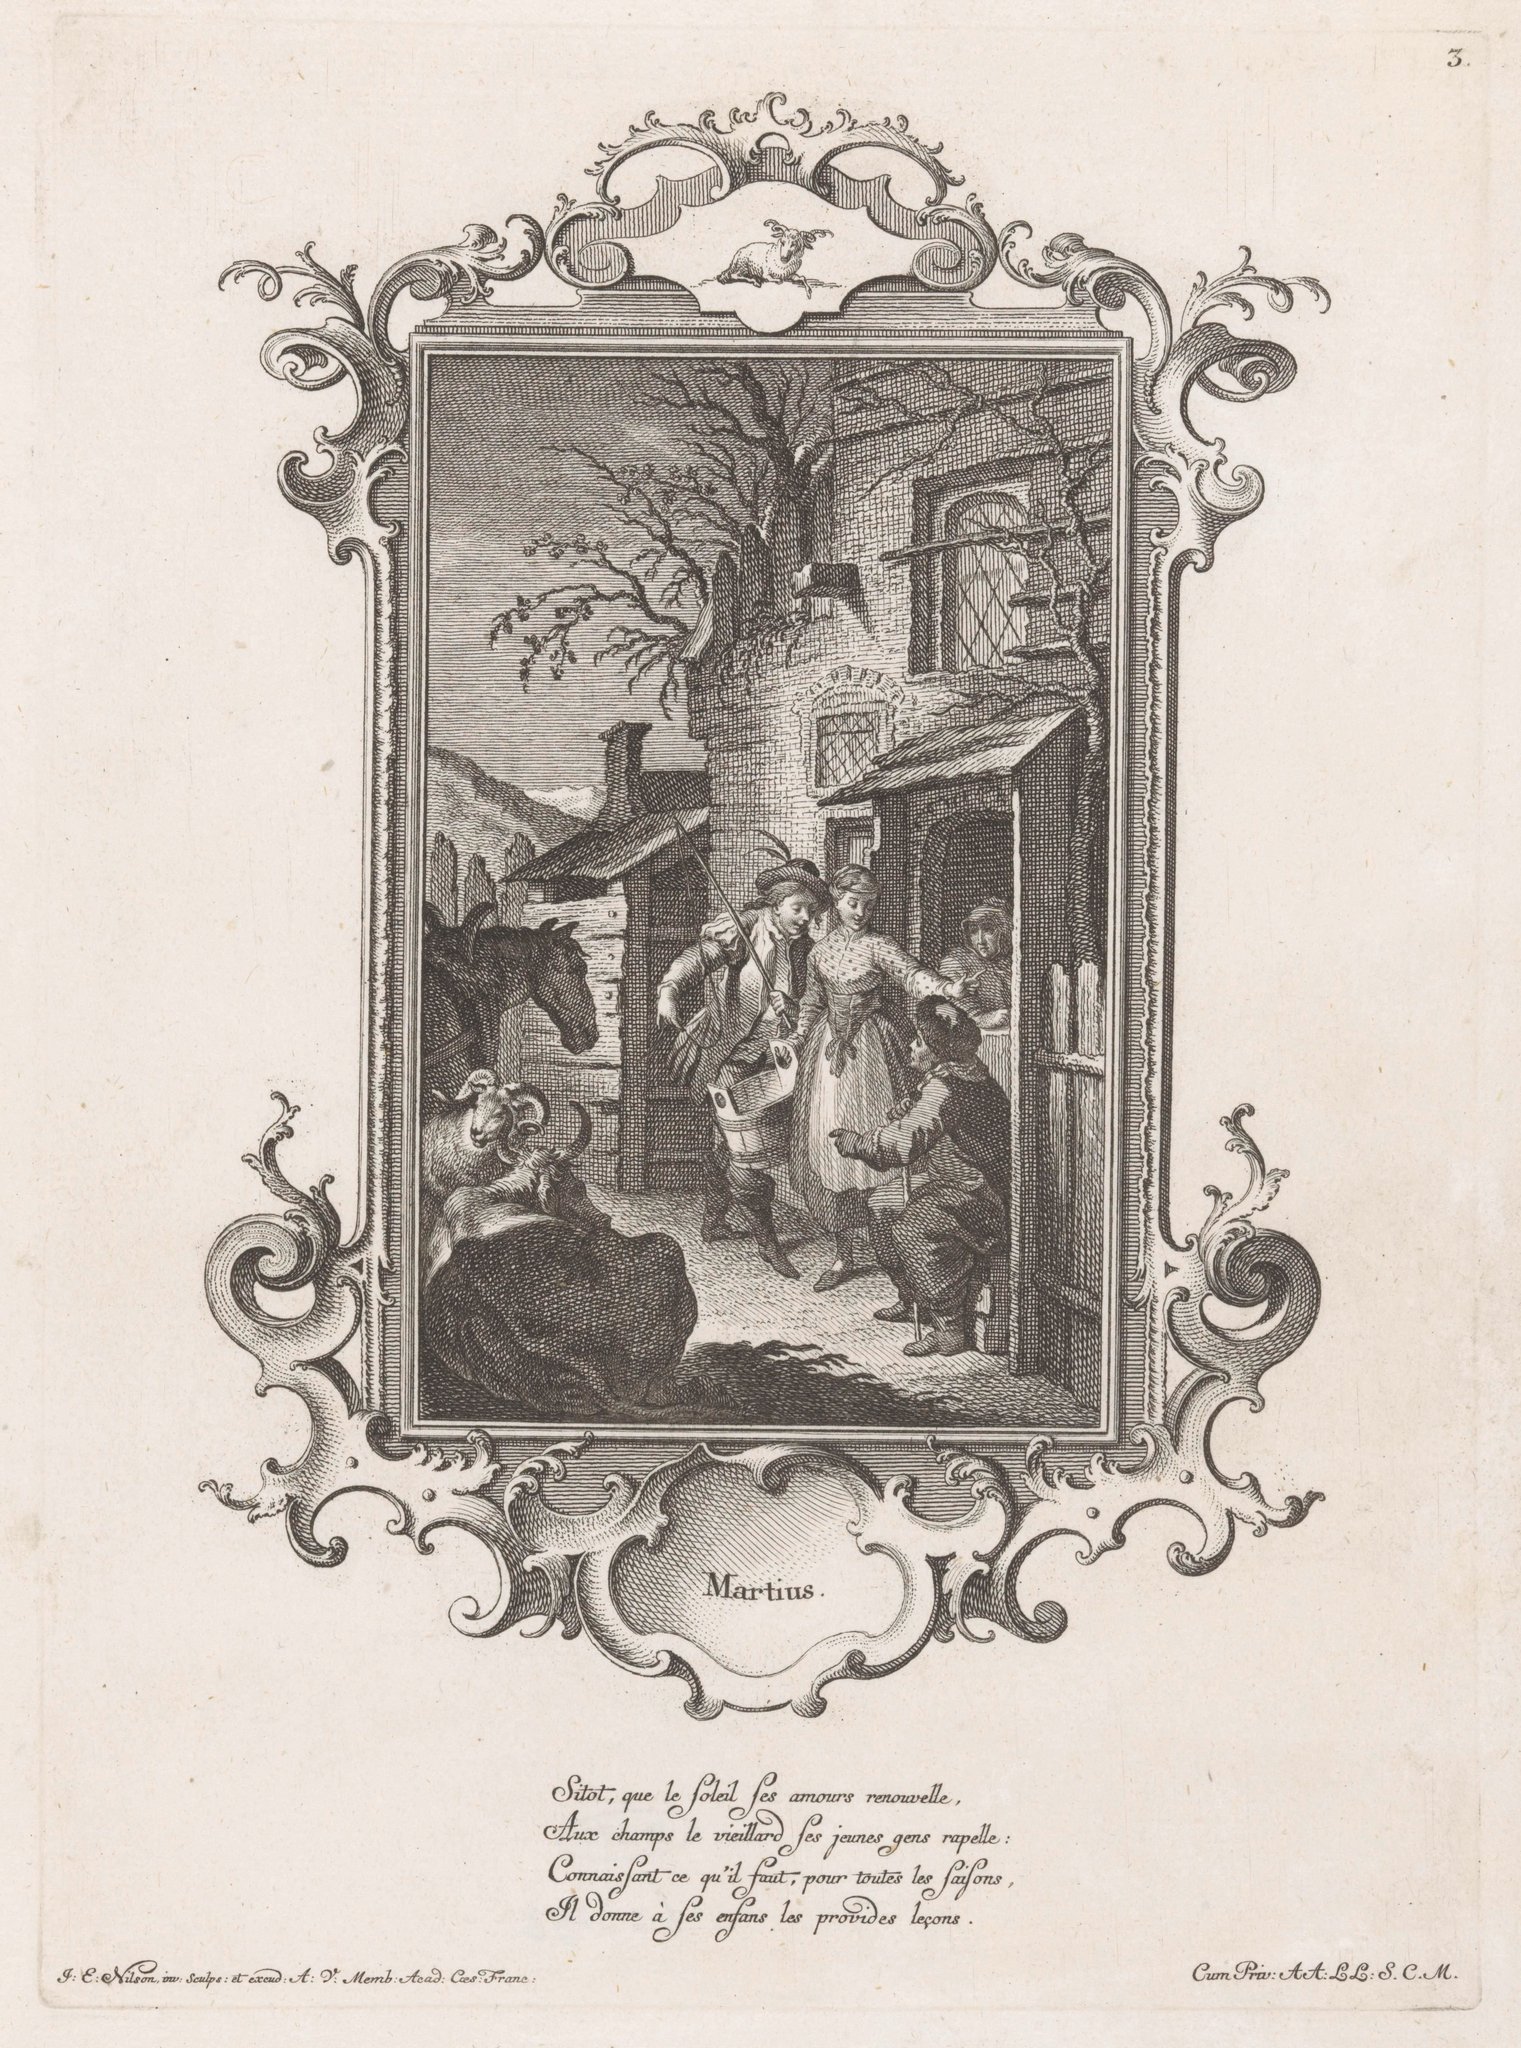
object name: print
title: De twaalf maanden van het jaar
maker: johann esaias nilson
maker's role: draughtsman, print maker, publisher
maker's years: 1721-1788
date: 1766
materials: paper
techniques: engraving, etching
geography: augsburg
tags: march and its 'labours', rural housing, e.g. country-house, villa, cottage, conversation, dialogue; conversation piece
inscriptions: collector's mark: Lugt 2228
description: In een rocaille omlijsting een voorstelling van een jong en een oud paar voor een boerenwoning. De jongeman en -vrouw luisteren naar advies van de oude man en vrouw. Links staan een paard, bok en rund. In de ondermarge een vierregelige Franse tekst.